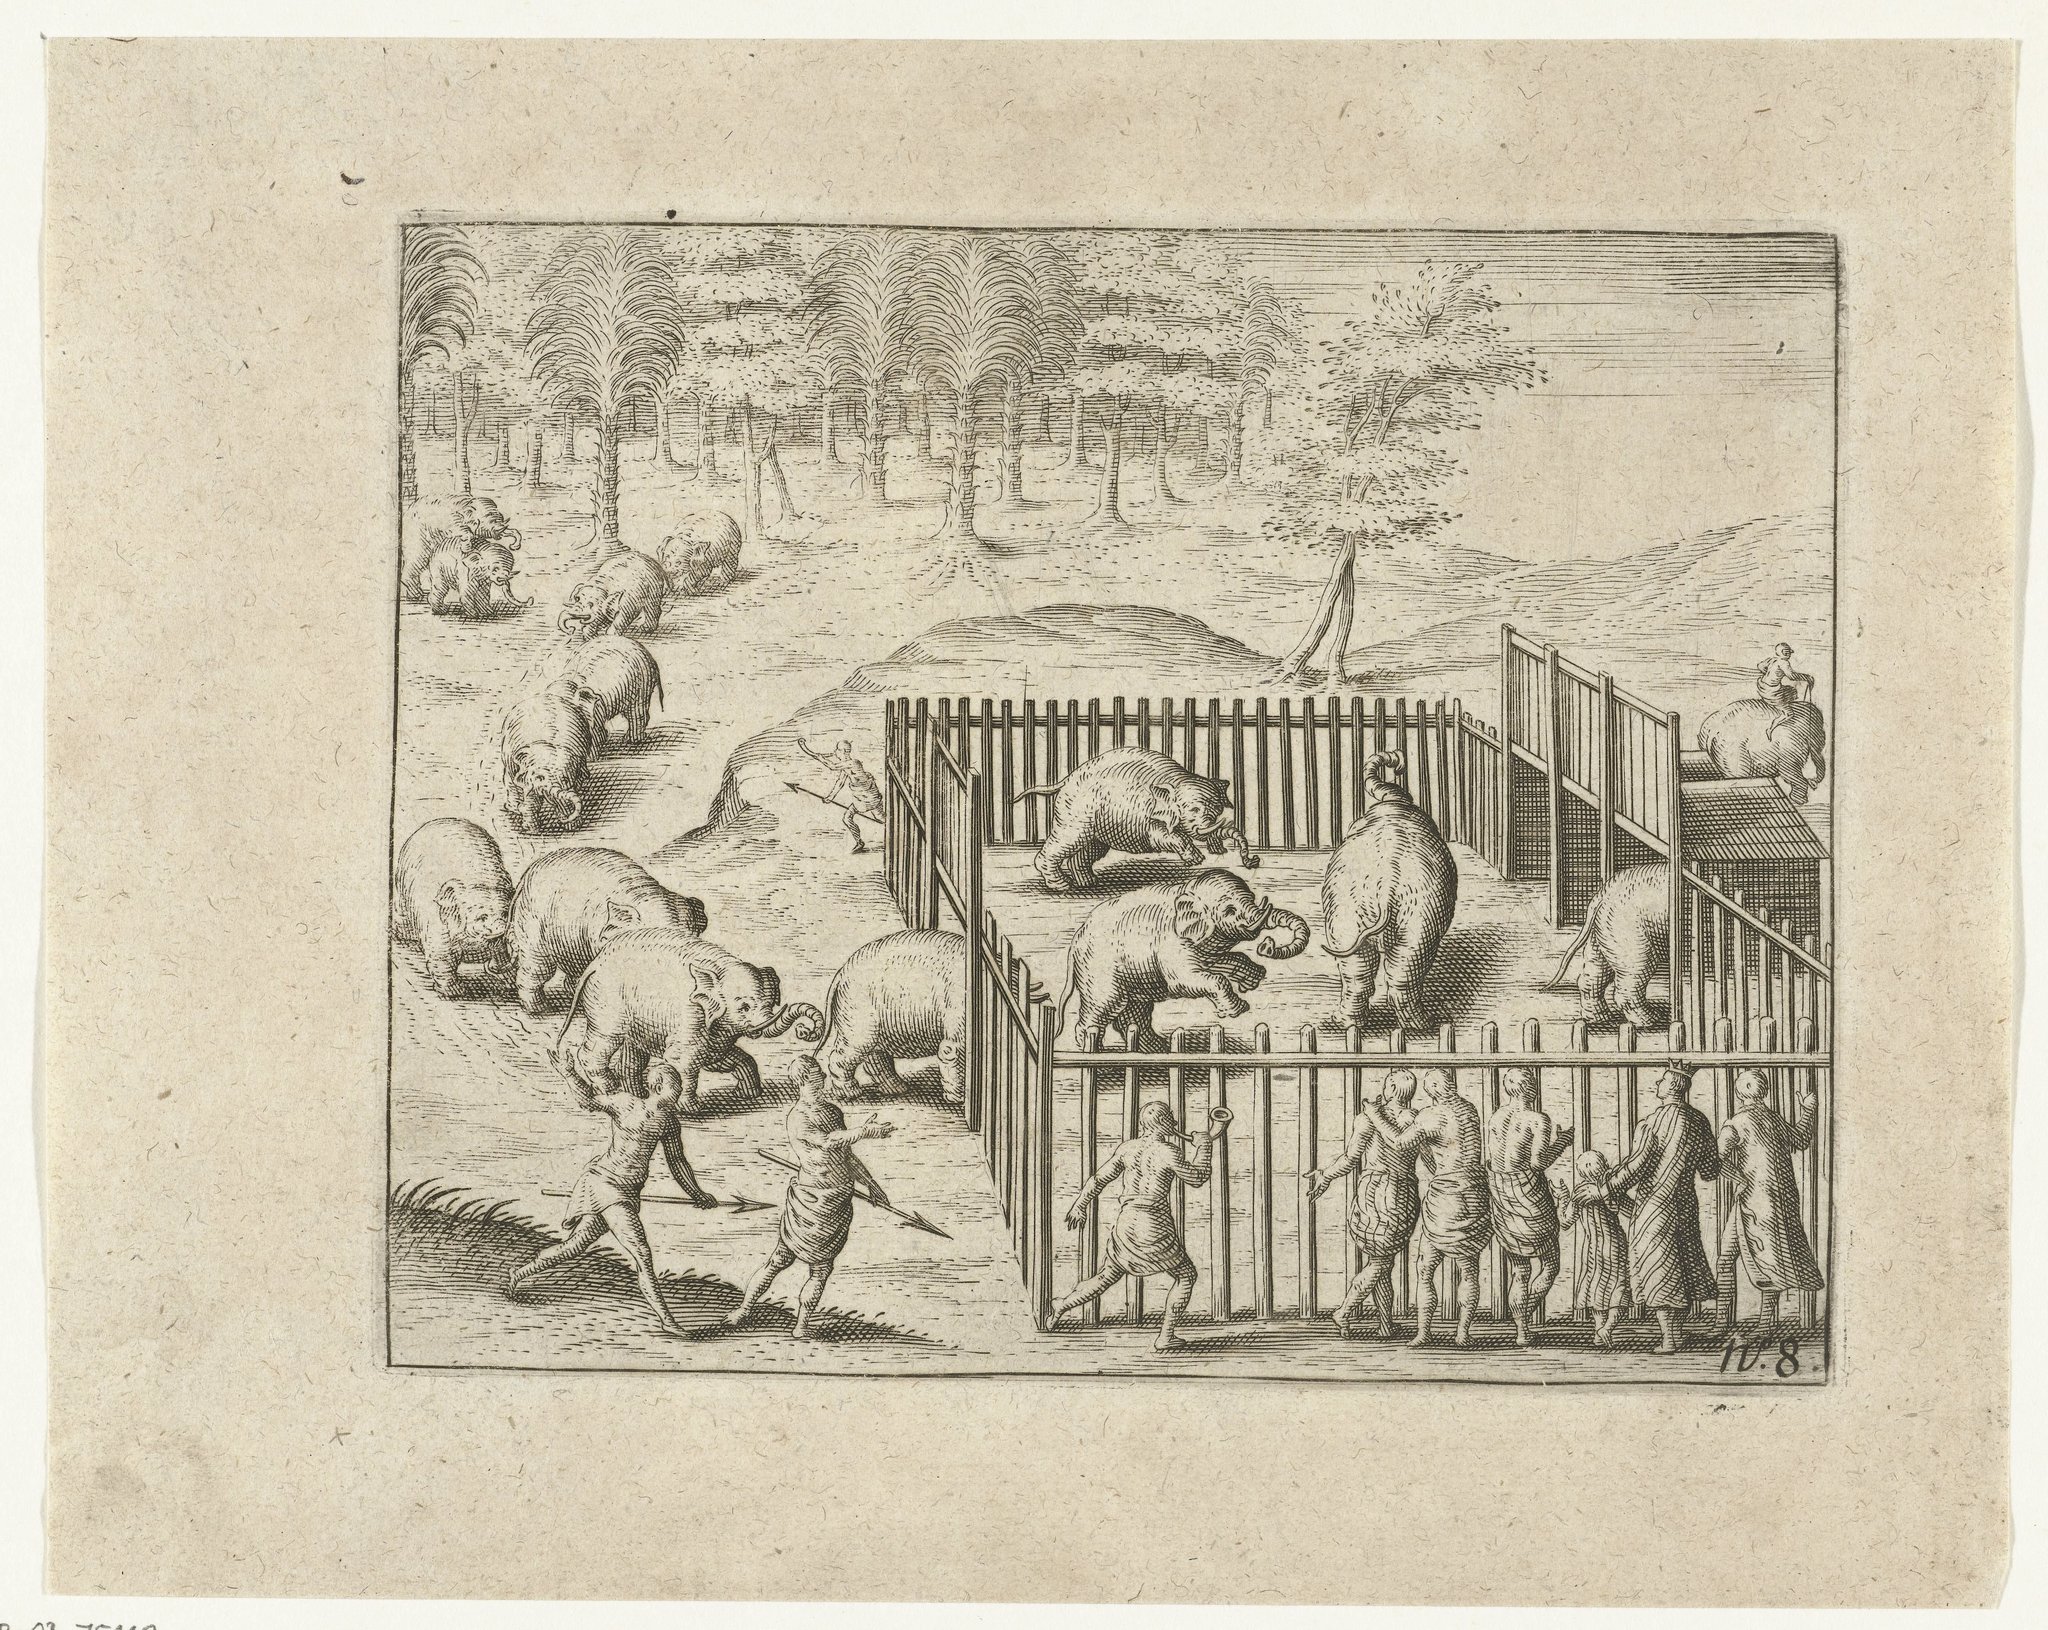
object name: print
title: Jacht op olifanten te Pegu, 1604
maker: Anonymous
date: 1644-1646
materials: paper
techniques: engraving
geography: northern netherlands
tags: hunting, chase, landscapes in tropical and sub-tropical regions, exploration, expedition, voyage of discovery, trunked animals: elephant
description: De oorspronkelijke platen eerst gebruikt in: Kort en¯ warachtich verhael vande heerlicke victorie (...) by de twaelf schepen afghevaren uyt Hollandt, ondert' ghebiedt vanden generael (...) Steven Verhaghen, in de eylanden vande Moluckes (Jan Jansz, Rotterdam, 1606) in de uitgave van De Bry, Petits Voyages, 1607. Deze kopieën gebruikt in: Beschrijvinghe van de tweede Voyagie, Ghedaen met 12. Schepen naer d'Oost-Indien. Onder den Heer Admirael Steven vander Hagen. Deze tekst opgenomen in : I. Commelin, Begin ende voortgangh, van de Vereenighde Nederlantsche Geoctroyeerde Oost-Indische Compagnie, J. Janssonius, Amsterdam 1646. Genummerd: 8.